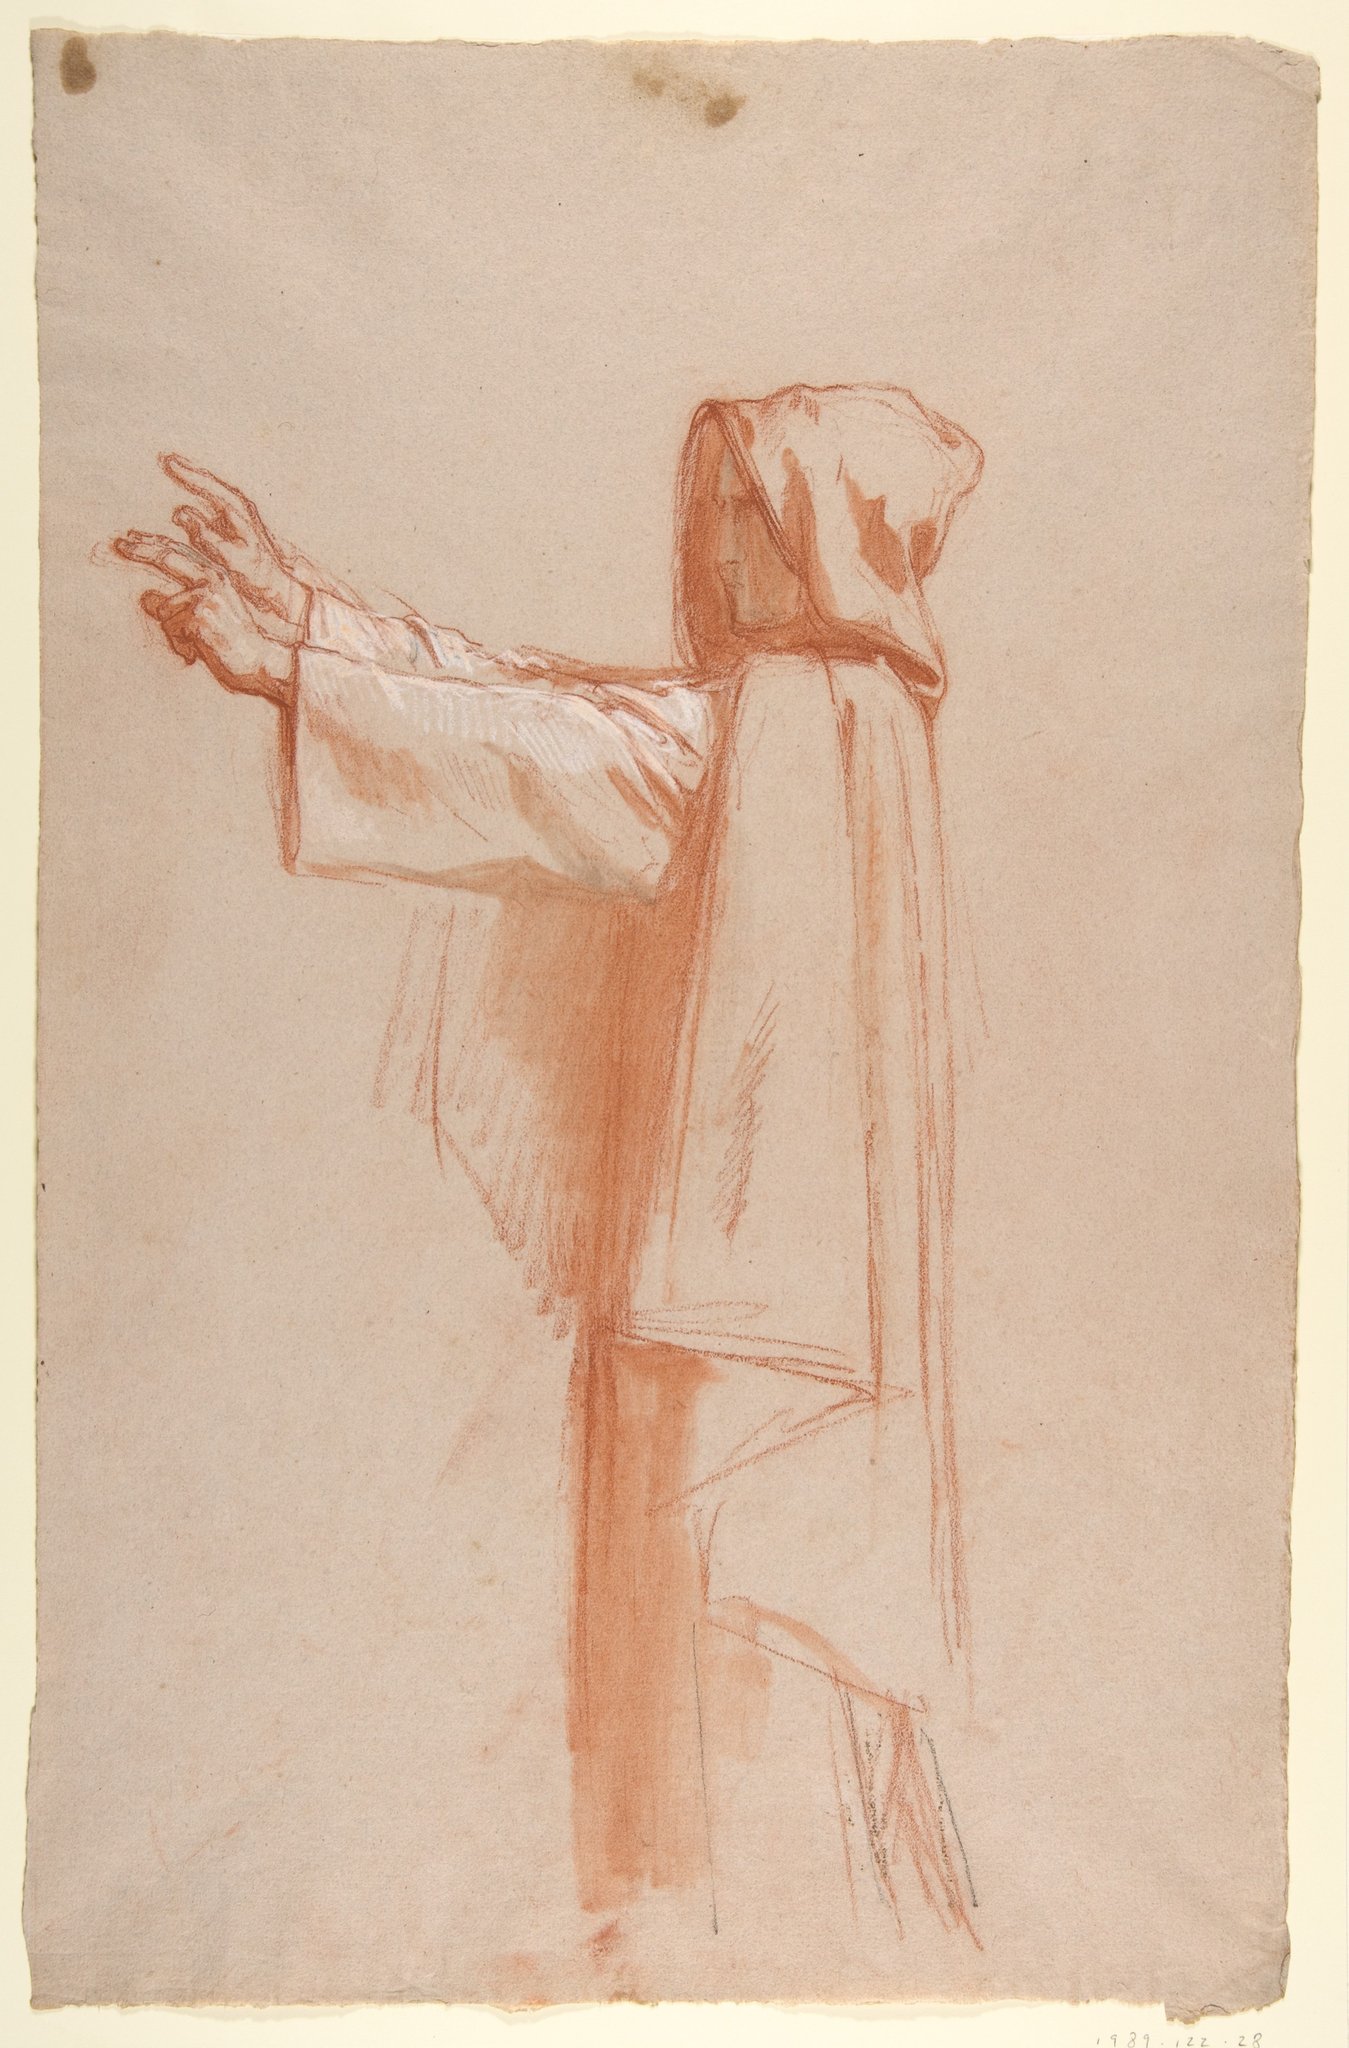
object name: drawing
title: Monk (lower register; study for wall paintings in the Chapel of Saint Remi, Sainte-Clotilde, Paris, 1858)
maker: isidore pils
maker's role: artist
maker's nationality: french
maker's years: 1813-1875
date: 1801-1900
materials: chalk, paper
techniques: heightening, stumping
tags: monks